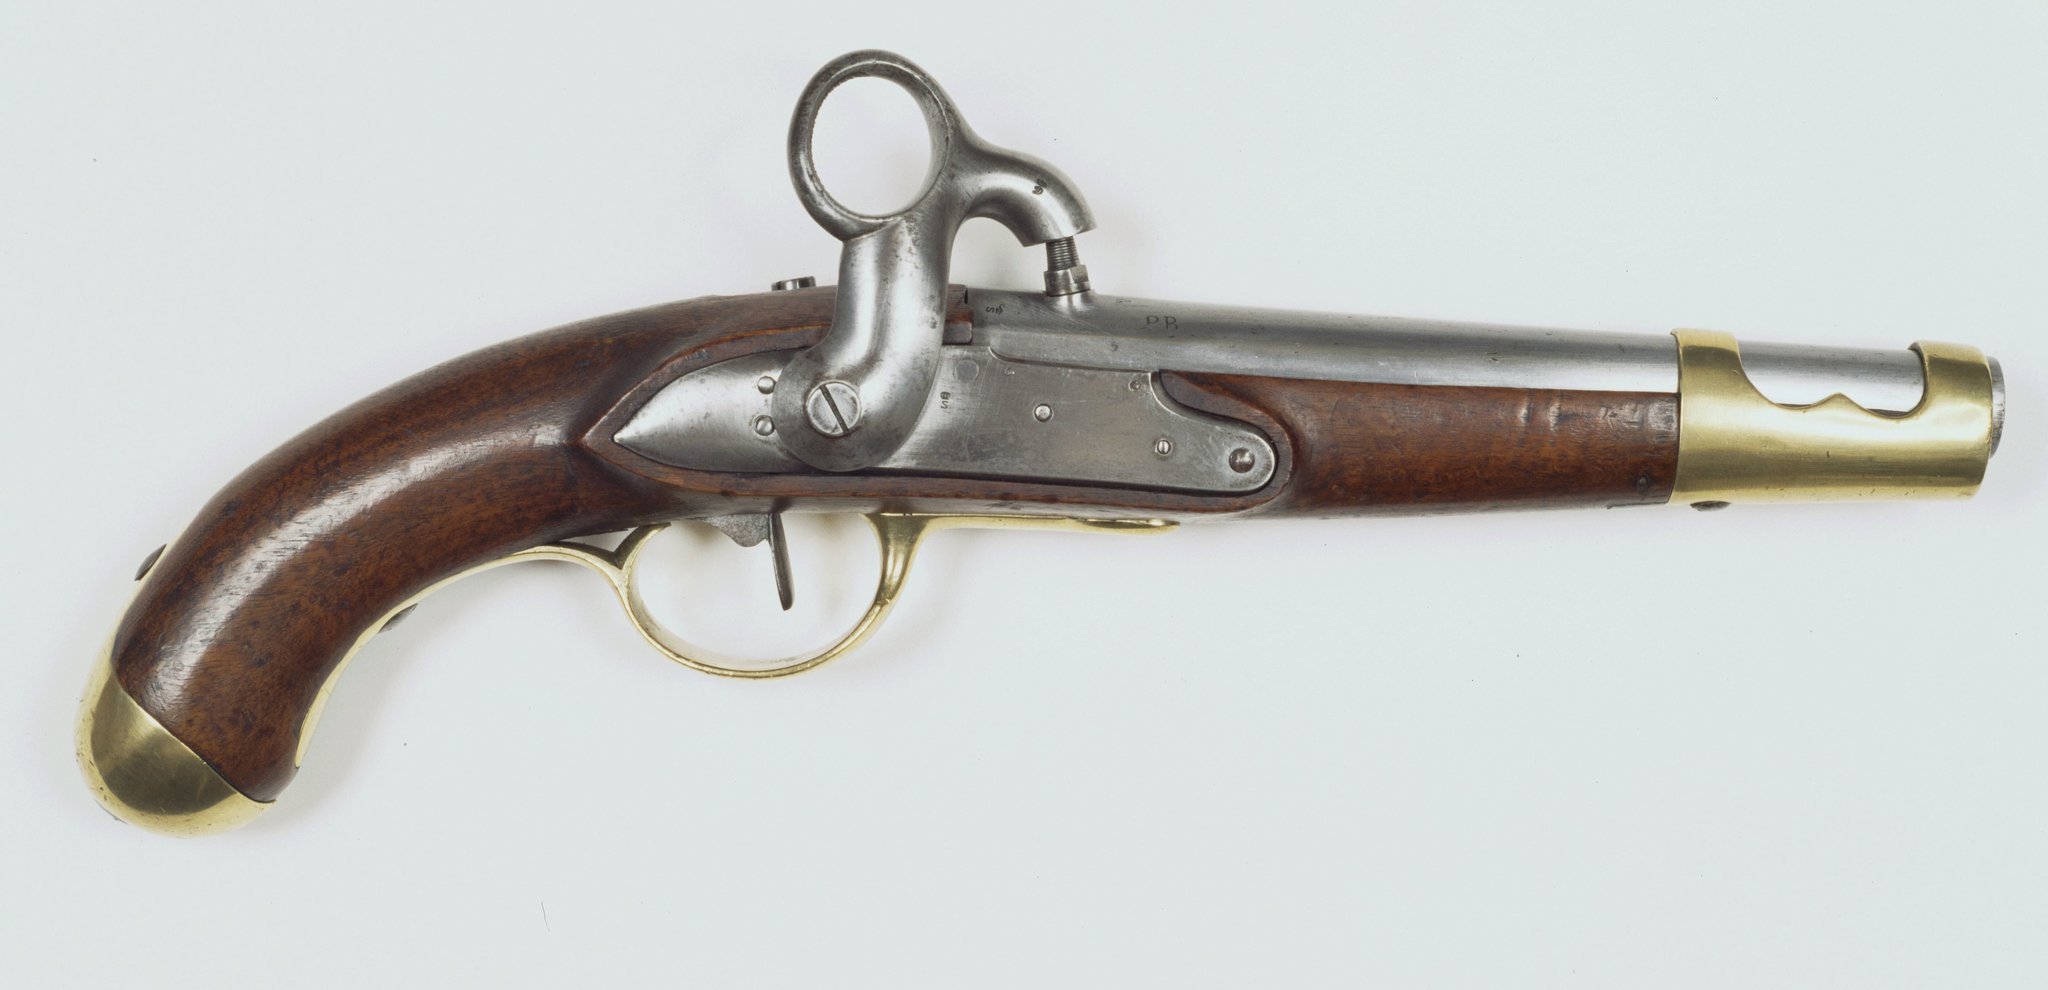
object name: percussion pistol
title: Percussie legerpistool model M 1815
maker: Anonymous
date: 1815-1816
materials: brass, iron, wood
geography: netherlands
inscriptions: signature: ‘JA met kroon’, signature: ‘I met kroon’, signature: ‘PB’, signature: ‘S met kroon’, signature: ‘D met kroon’, signature: ‘S’, signature: ‘S met kroon’